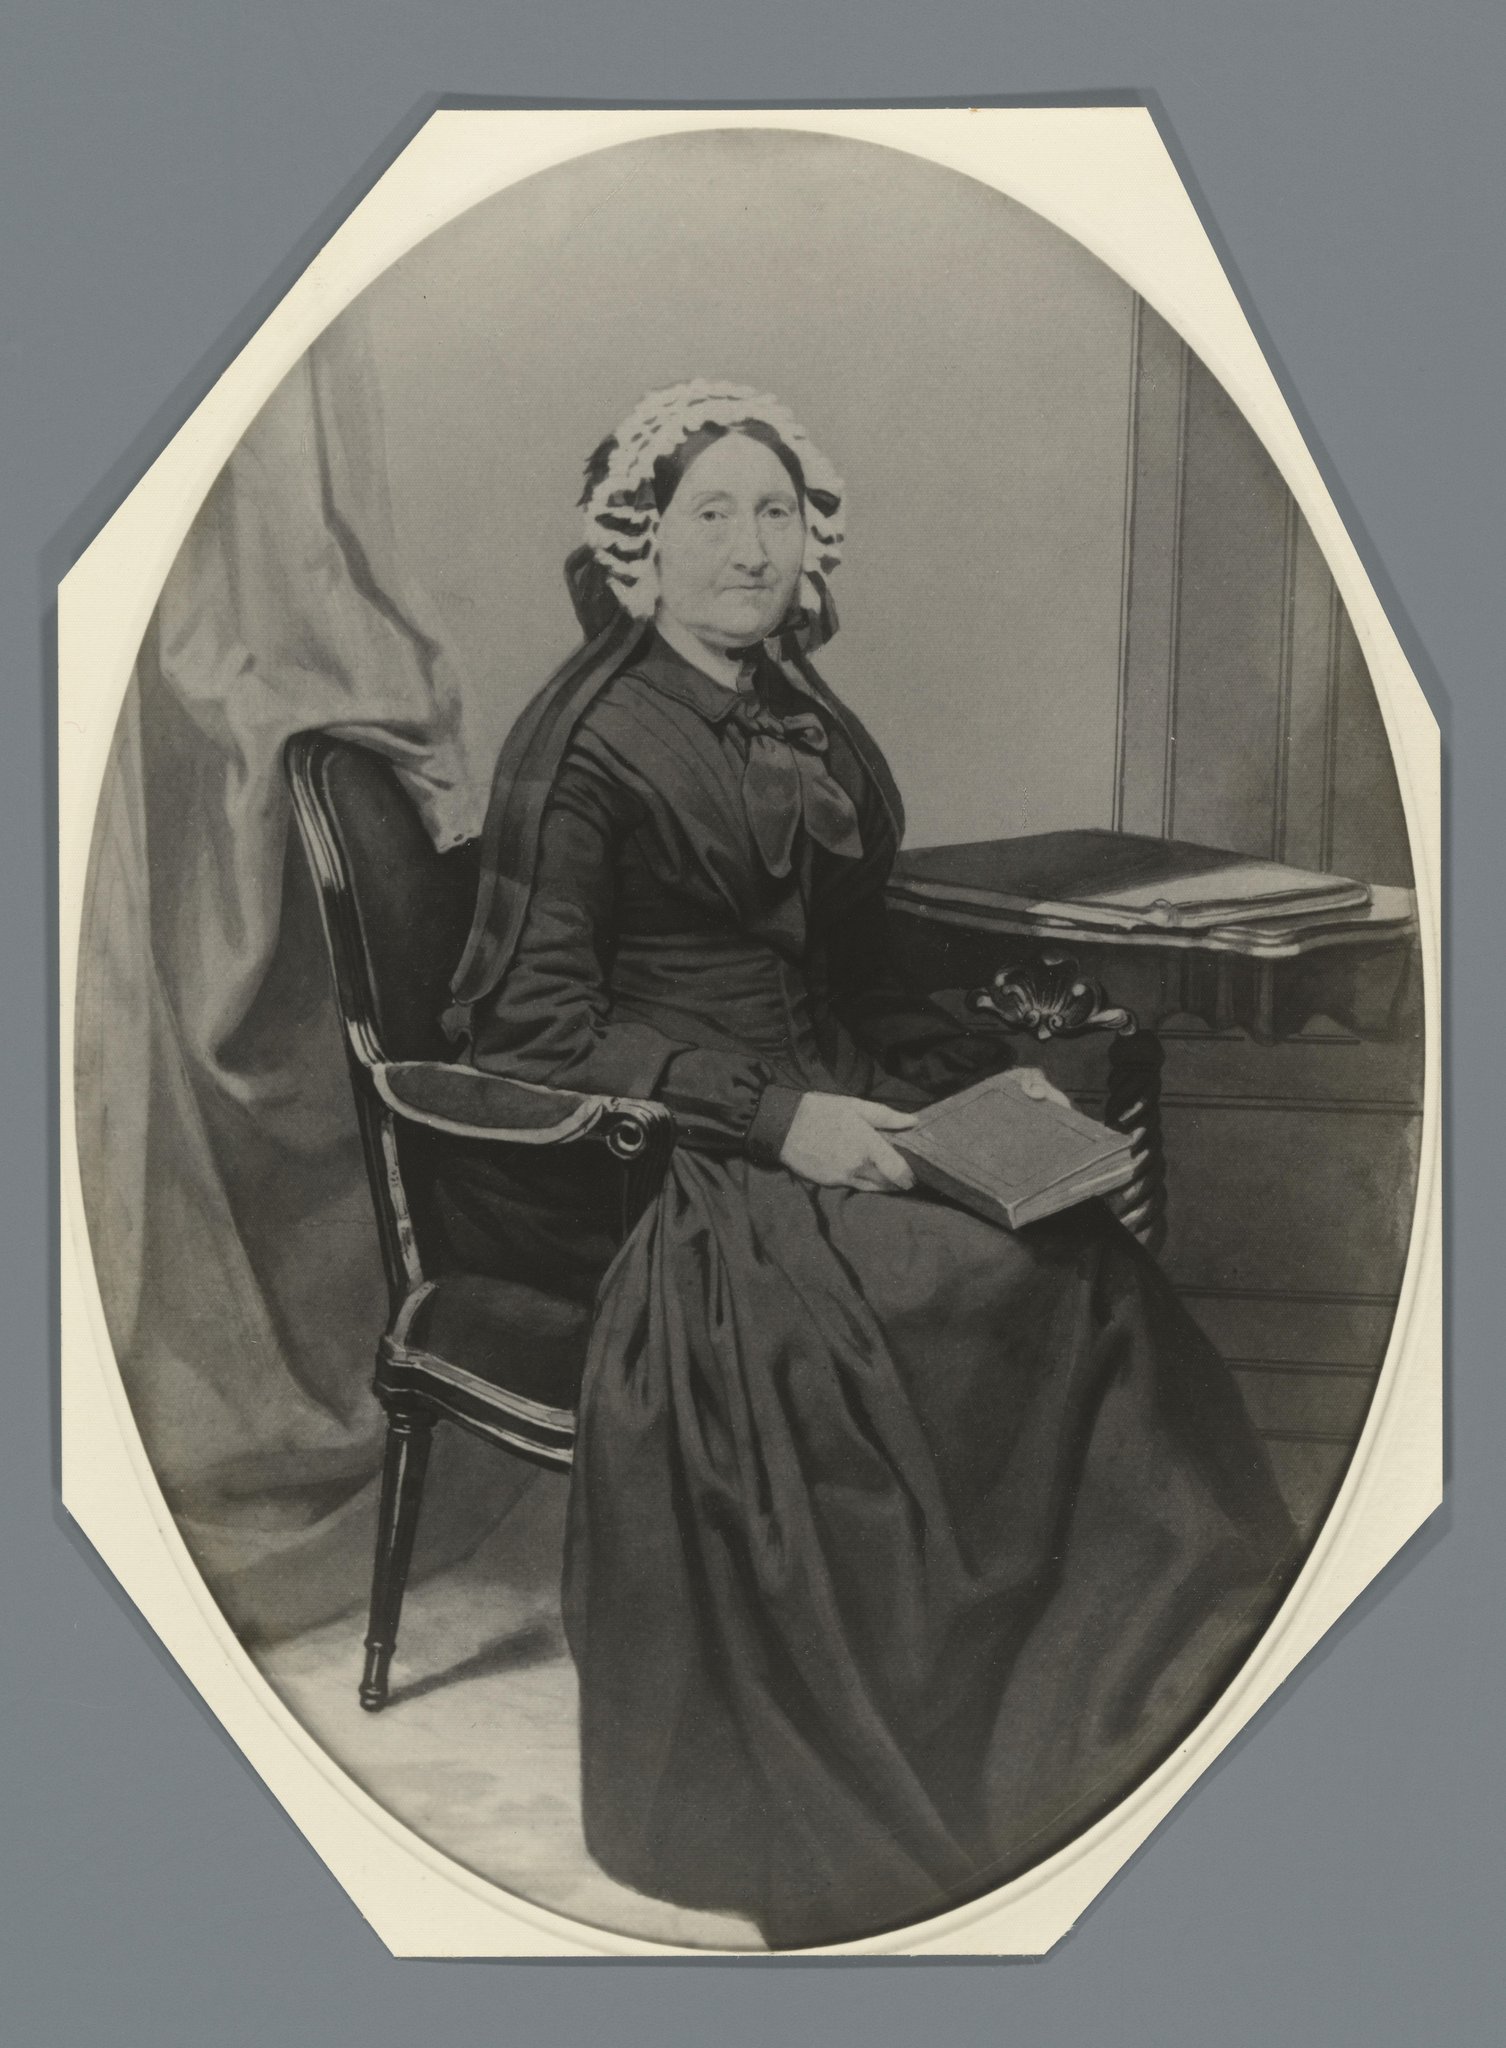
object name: photograph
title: Portret van Sara Swellengrebel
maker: Anonymous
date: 1875-1890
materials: cardboard, photographic support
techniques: gelatin silver print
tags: utrecht, historical persons - bb - woman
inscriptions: inscription: ‘Mevr. Royaards Swellengrebel / Sara Swellengrebel oudste dochter van Johan Gerard Sw en Anna Henriette v Ewijck / 1803-1891’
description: Ovaal portret van Sara Royaards-Swellengrebel (1803-1891), zittend aan een bureau, een boek in de hand.